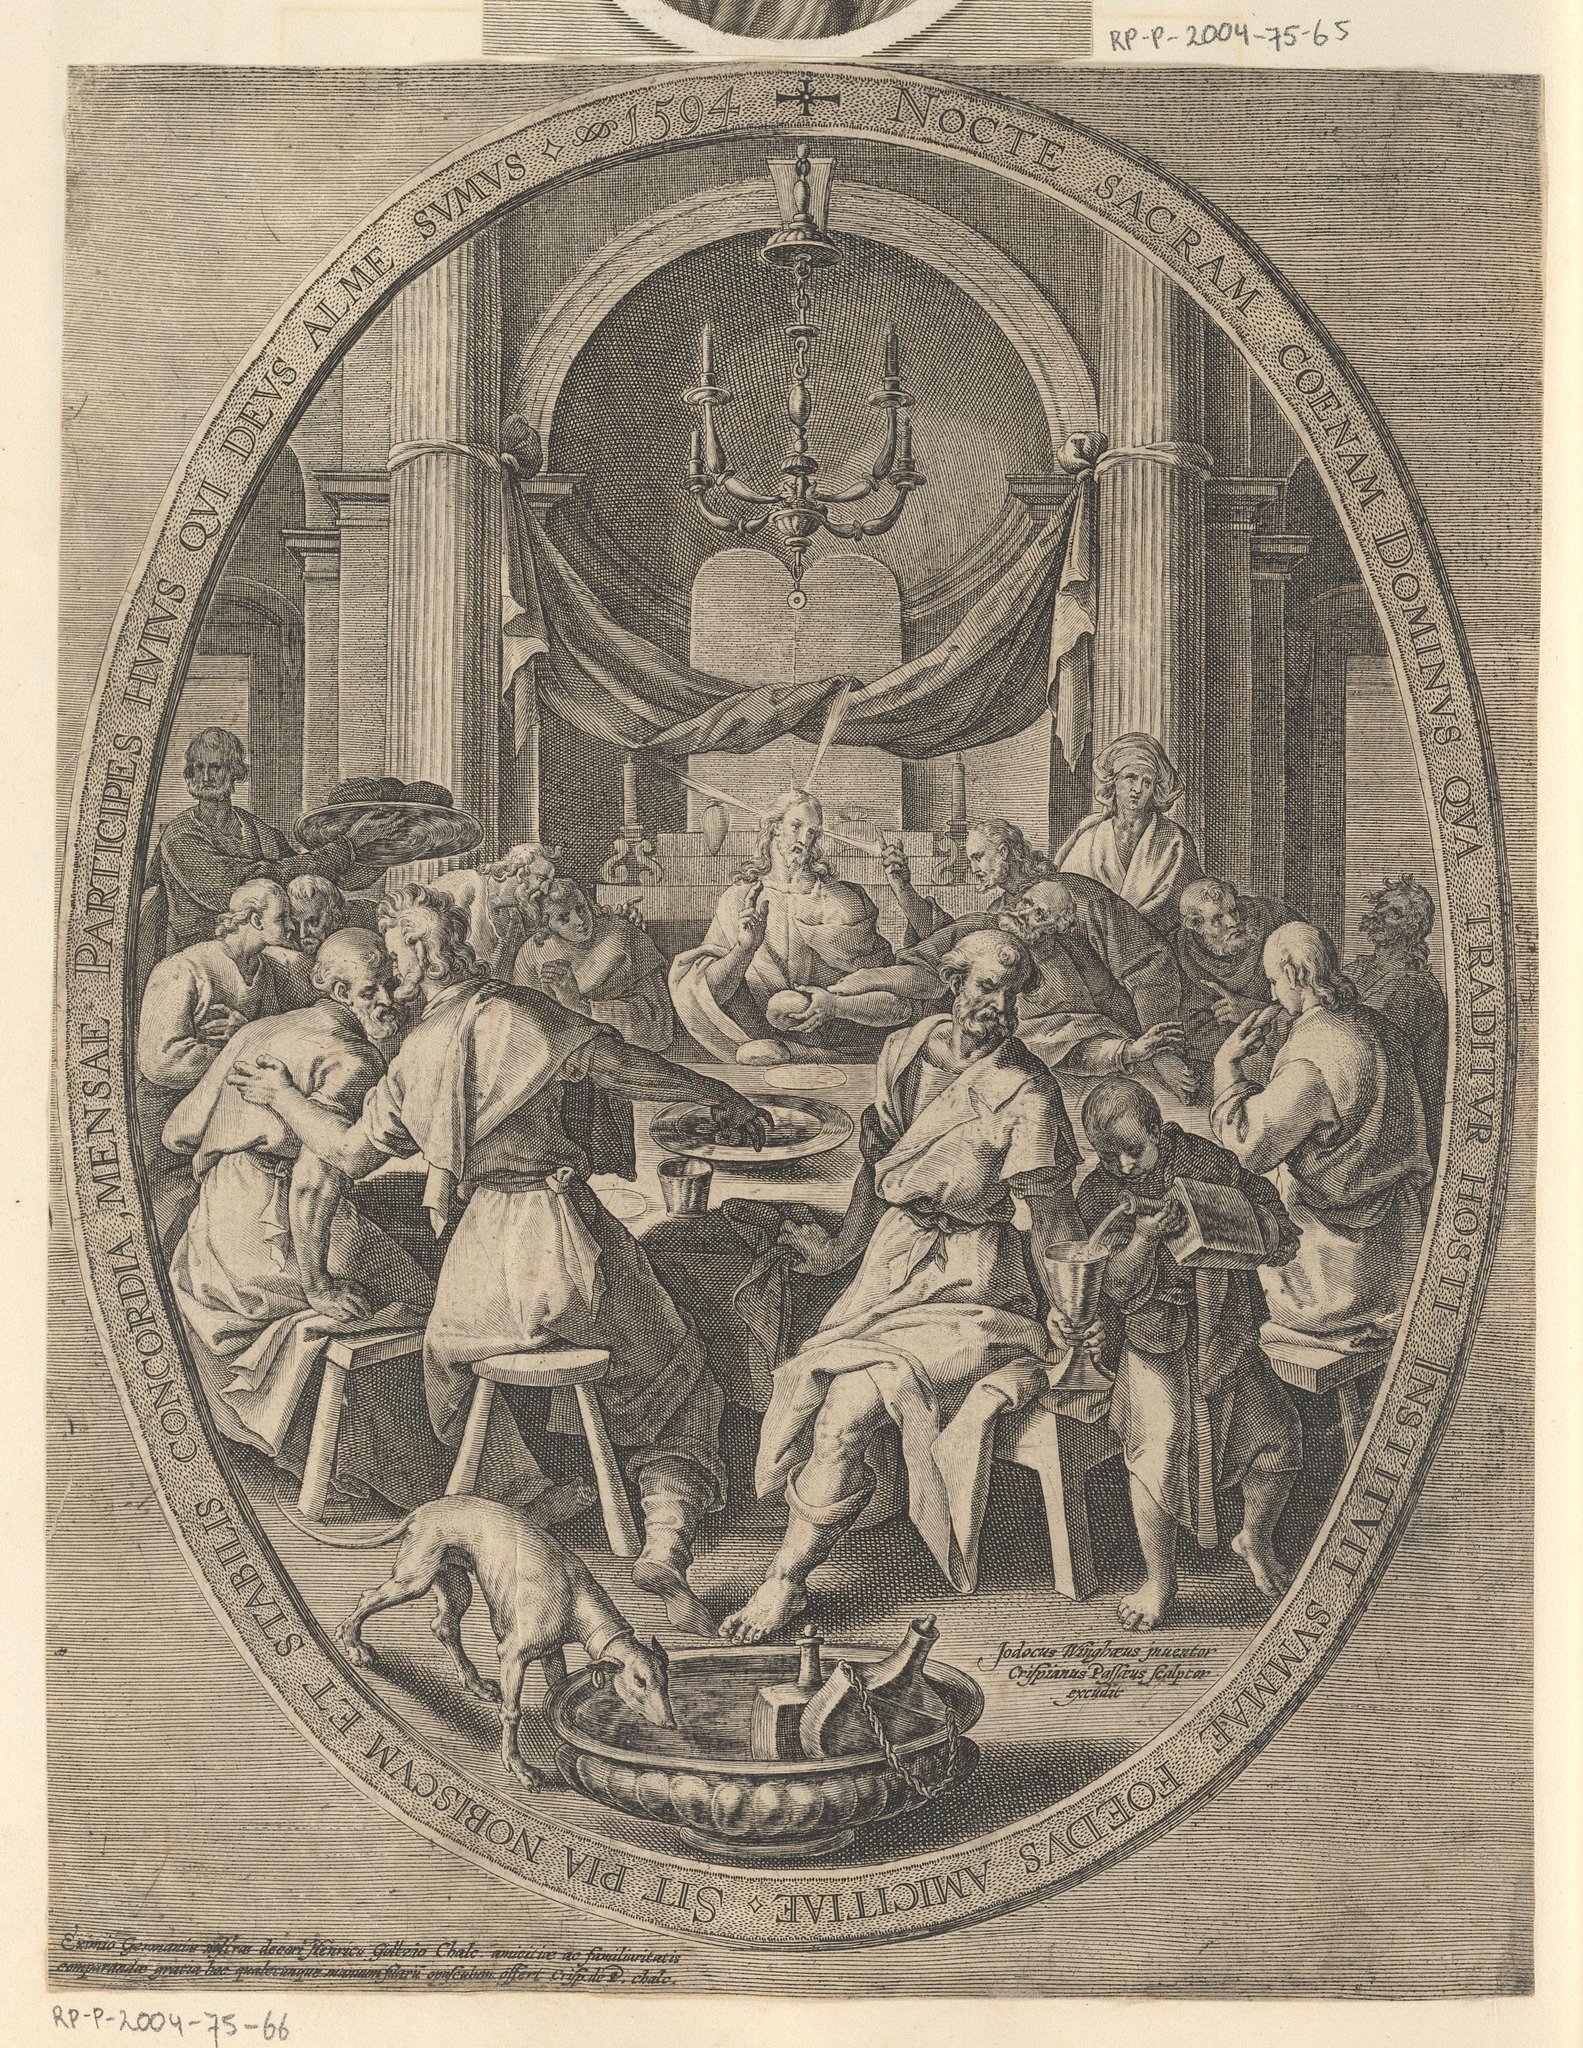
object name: print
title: Laatste Avondmaal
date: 1594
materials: paper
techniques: engraving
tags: last supper (in general) (matthew 26:21-35; mark 14:18-31; luke 22:3, 22:15-23; john 13:21-38)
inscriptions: date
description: De samensteller heeft deze prent in het album geplakt als illustratie bij: Pilkington, Matthew en Johann Heinrich Füssli. A dictionary of painters, from the revival of the art to the present period. 4 dln. Londen: John Crowder, 1805, dl. 4, p. 649.